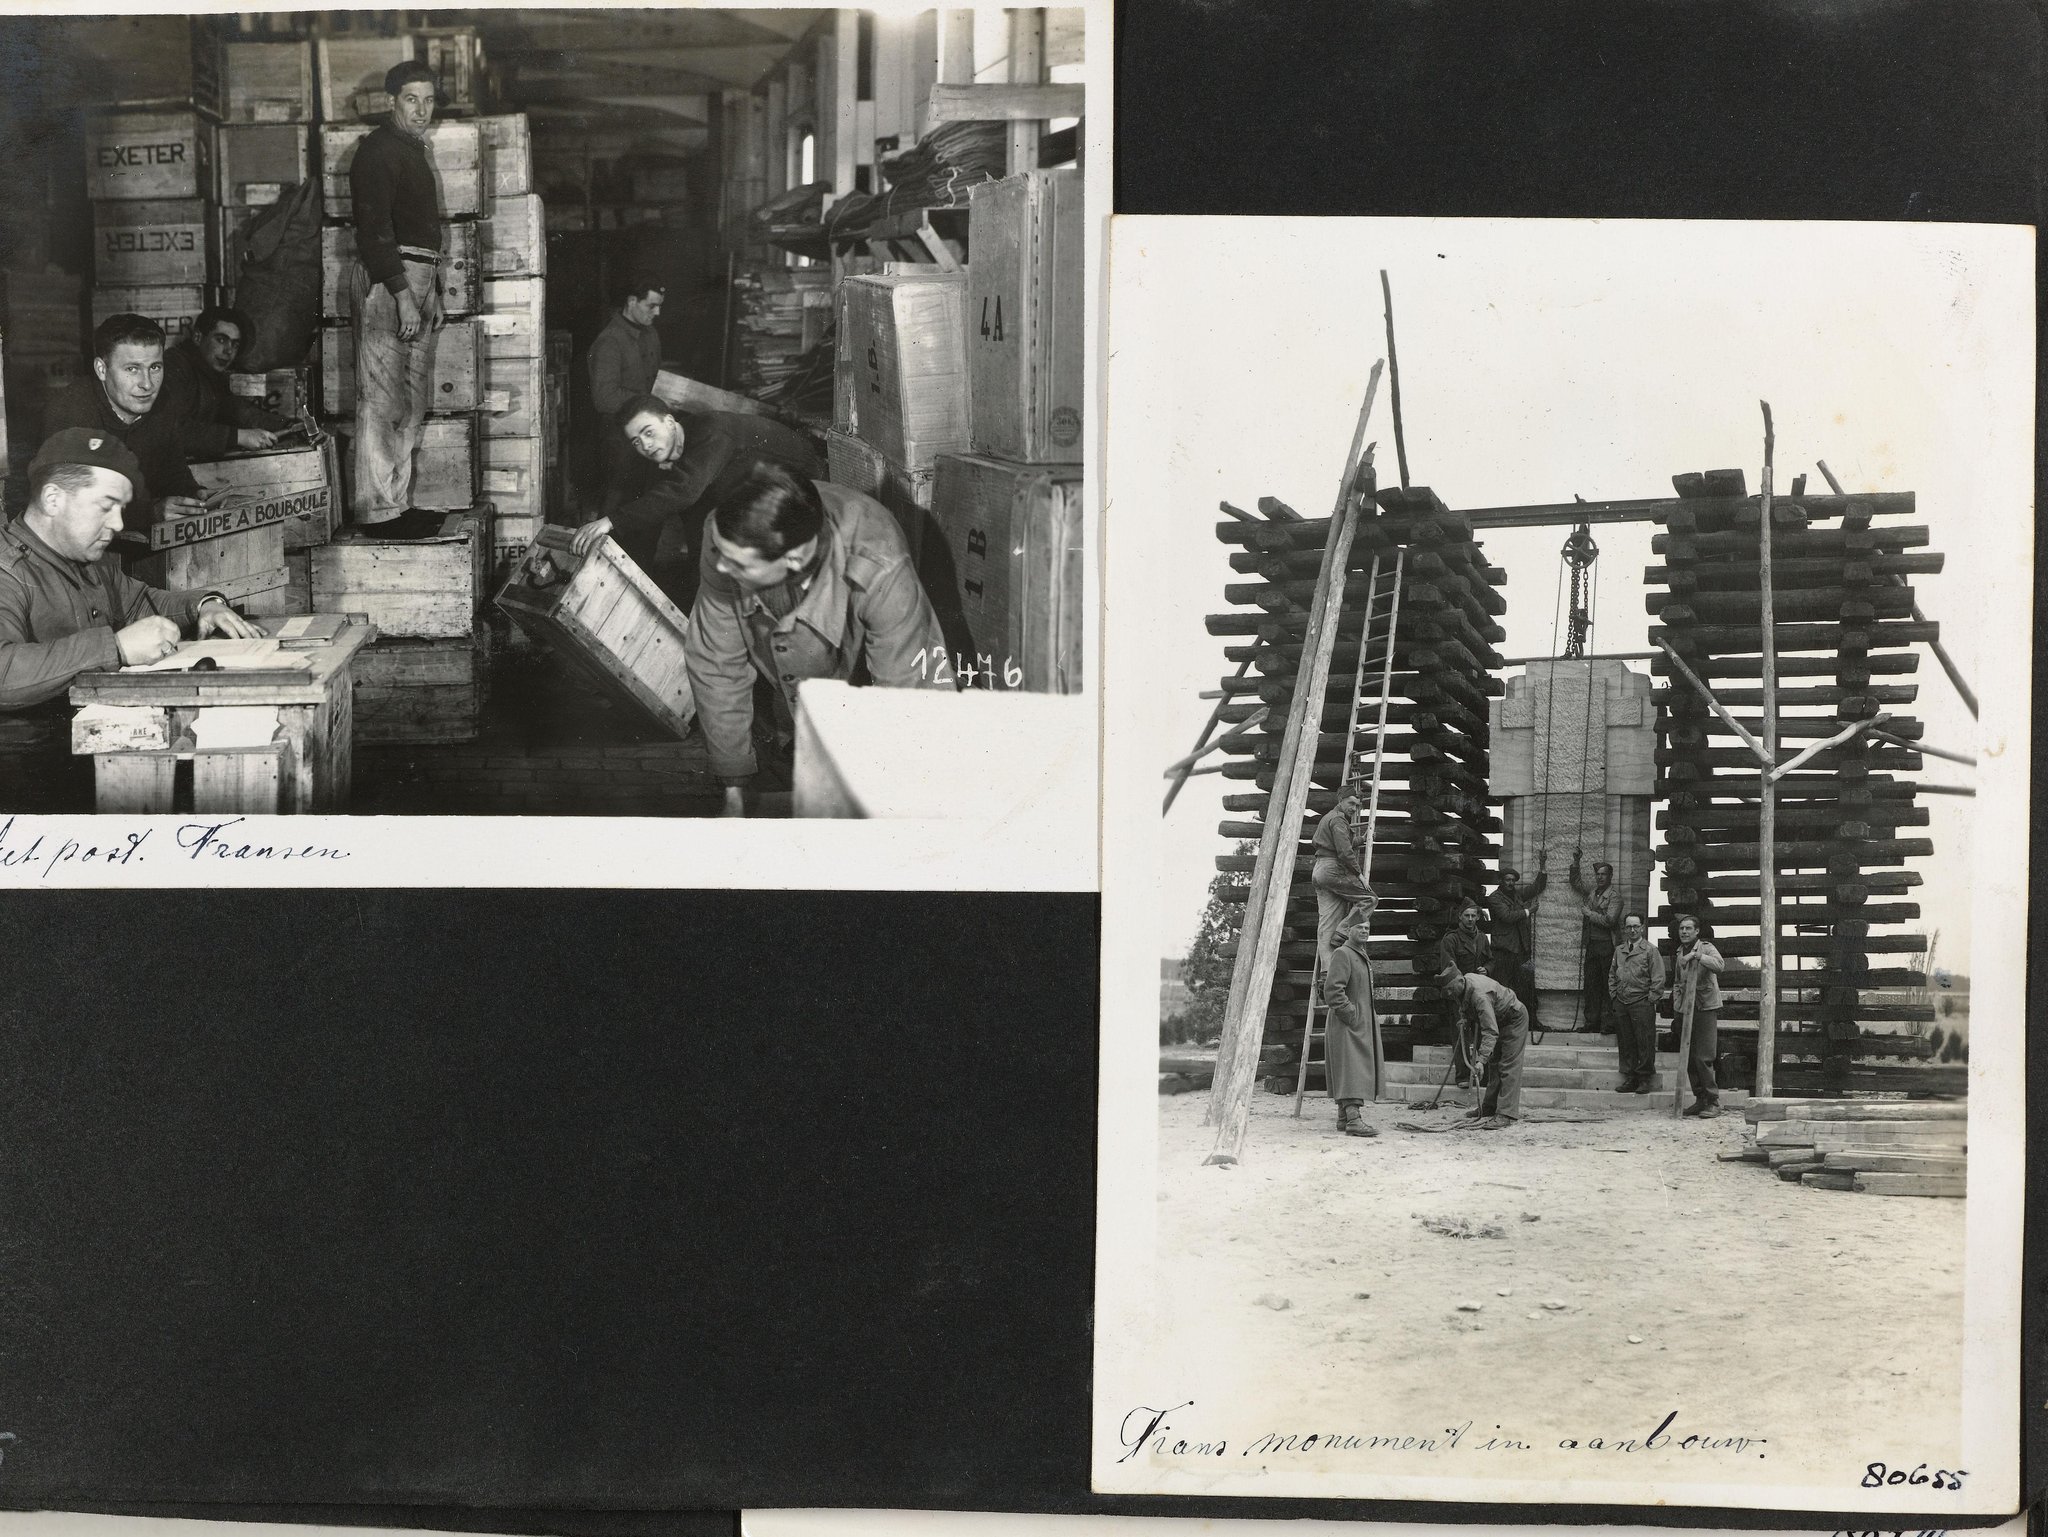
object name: photograph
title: Pakketpost Fransen / Frans monument in aanbouw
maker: dick w.b. van maarseveen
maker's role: fotograaf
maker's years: 1905-1990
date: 1943-1945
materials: cardboard, photographic support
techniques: gelatin silver print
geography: muhlberg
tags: dick w.b. van maarseveen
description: Albumblad met twee foto's: verzorging van pakketpost door Franse gevangenen en de bouw van een monument door Franse gevangenen. Onderdeel van een fotoalbum met foto's door Dick van Maarseveen van het krijgsgevangenenkamp Stalag IV B in Mühlberg in de periode 1943-1945.